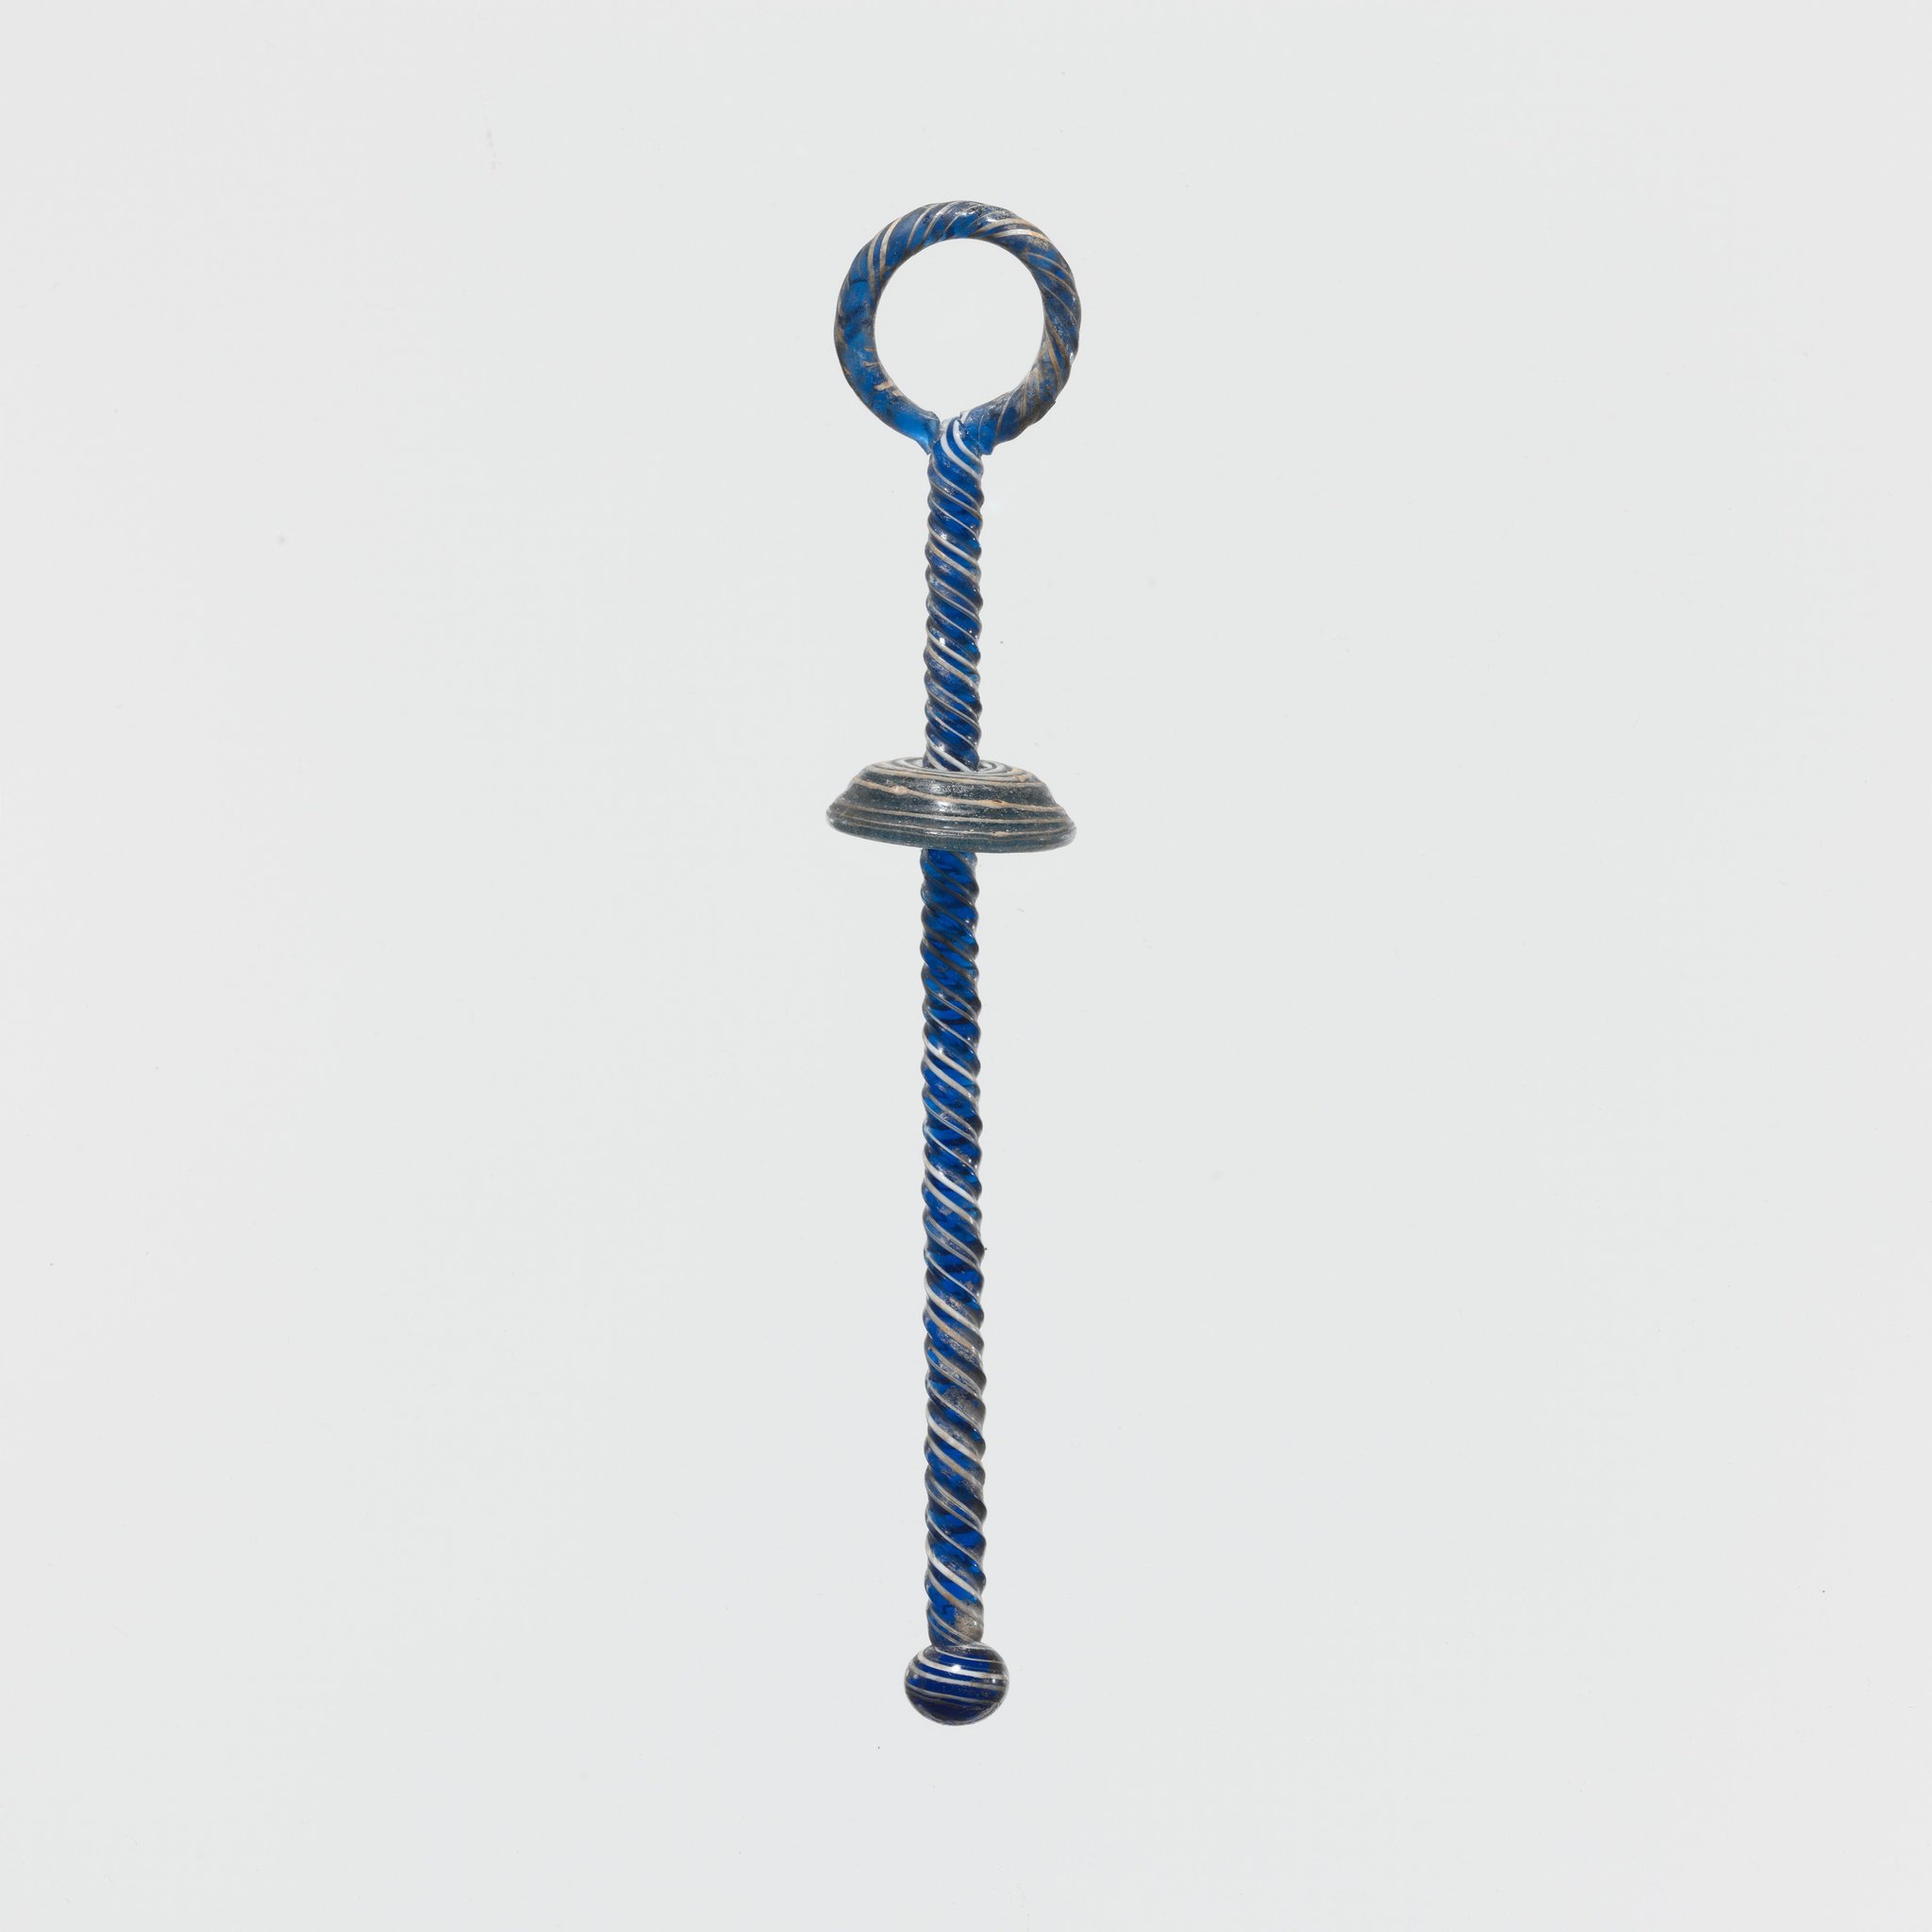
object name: stirring rod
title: Glass stirring rod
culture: roman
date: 1-100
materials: glass